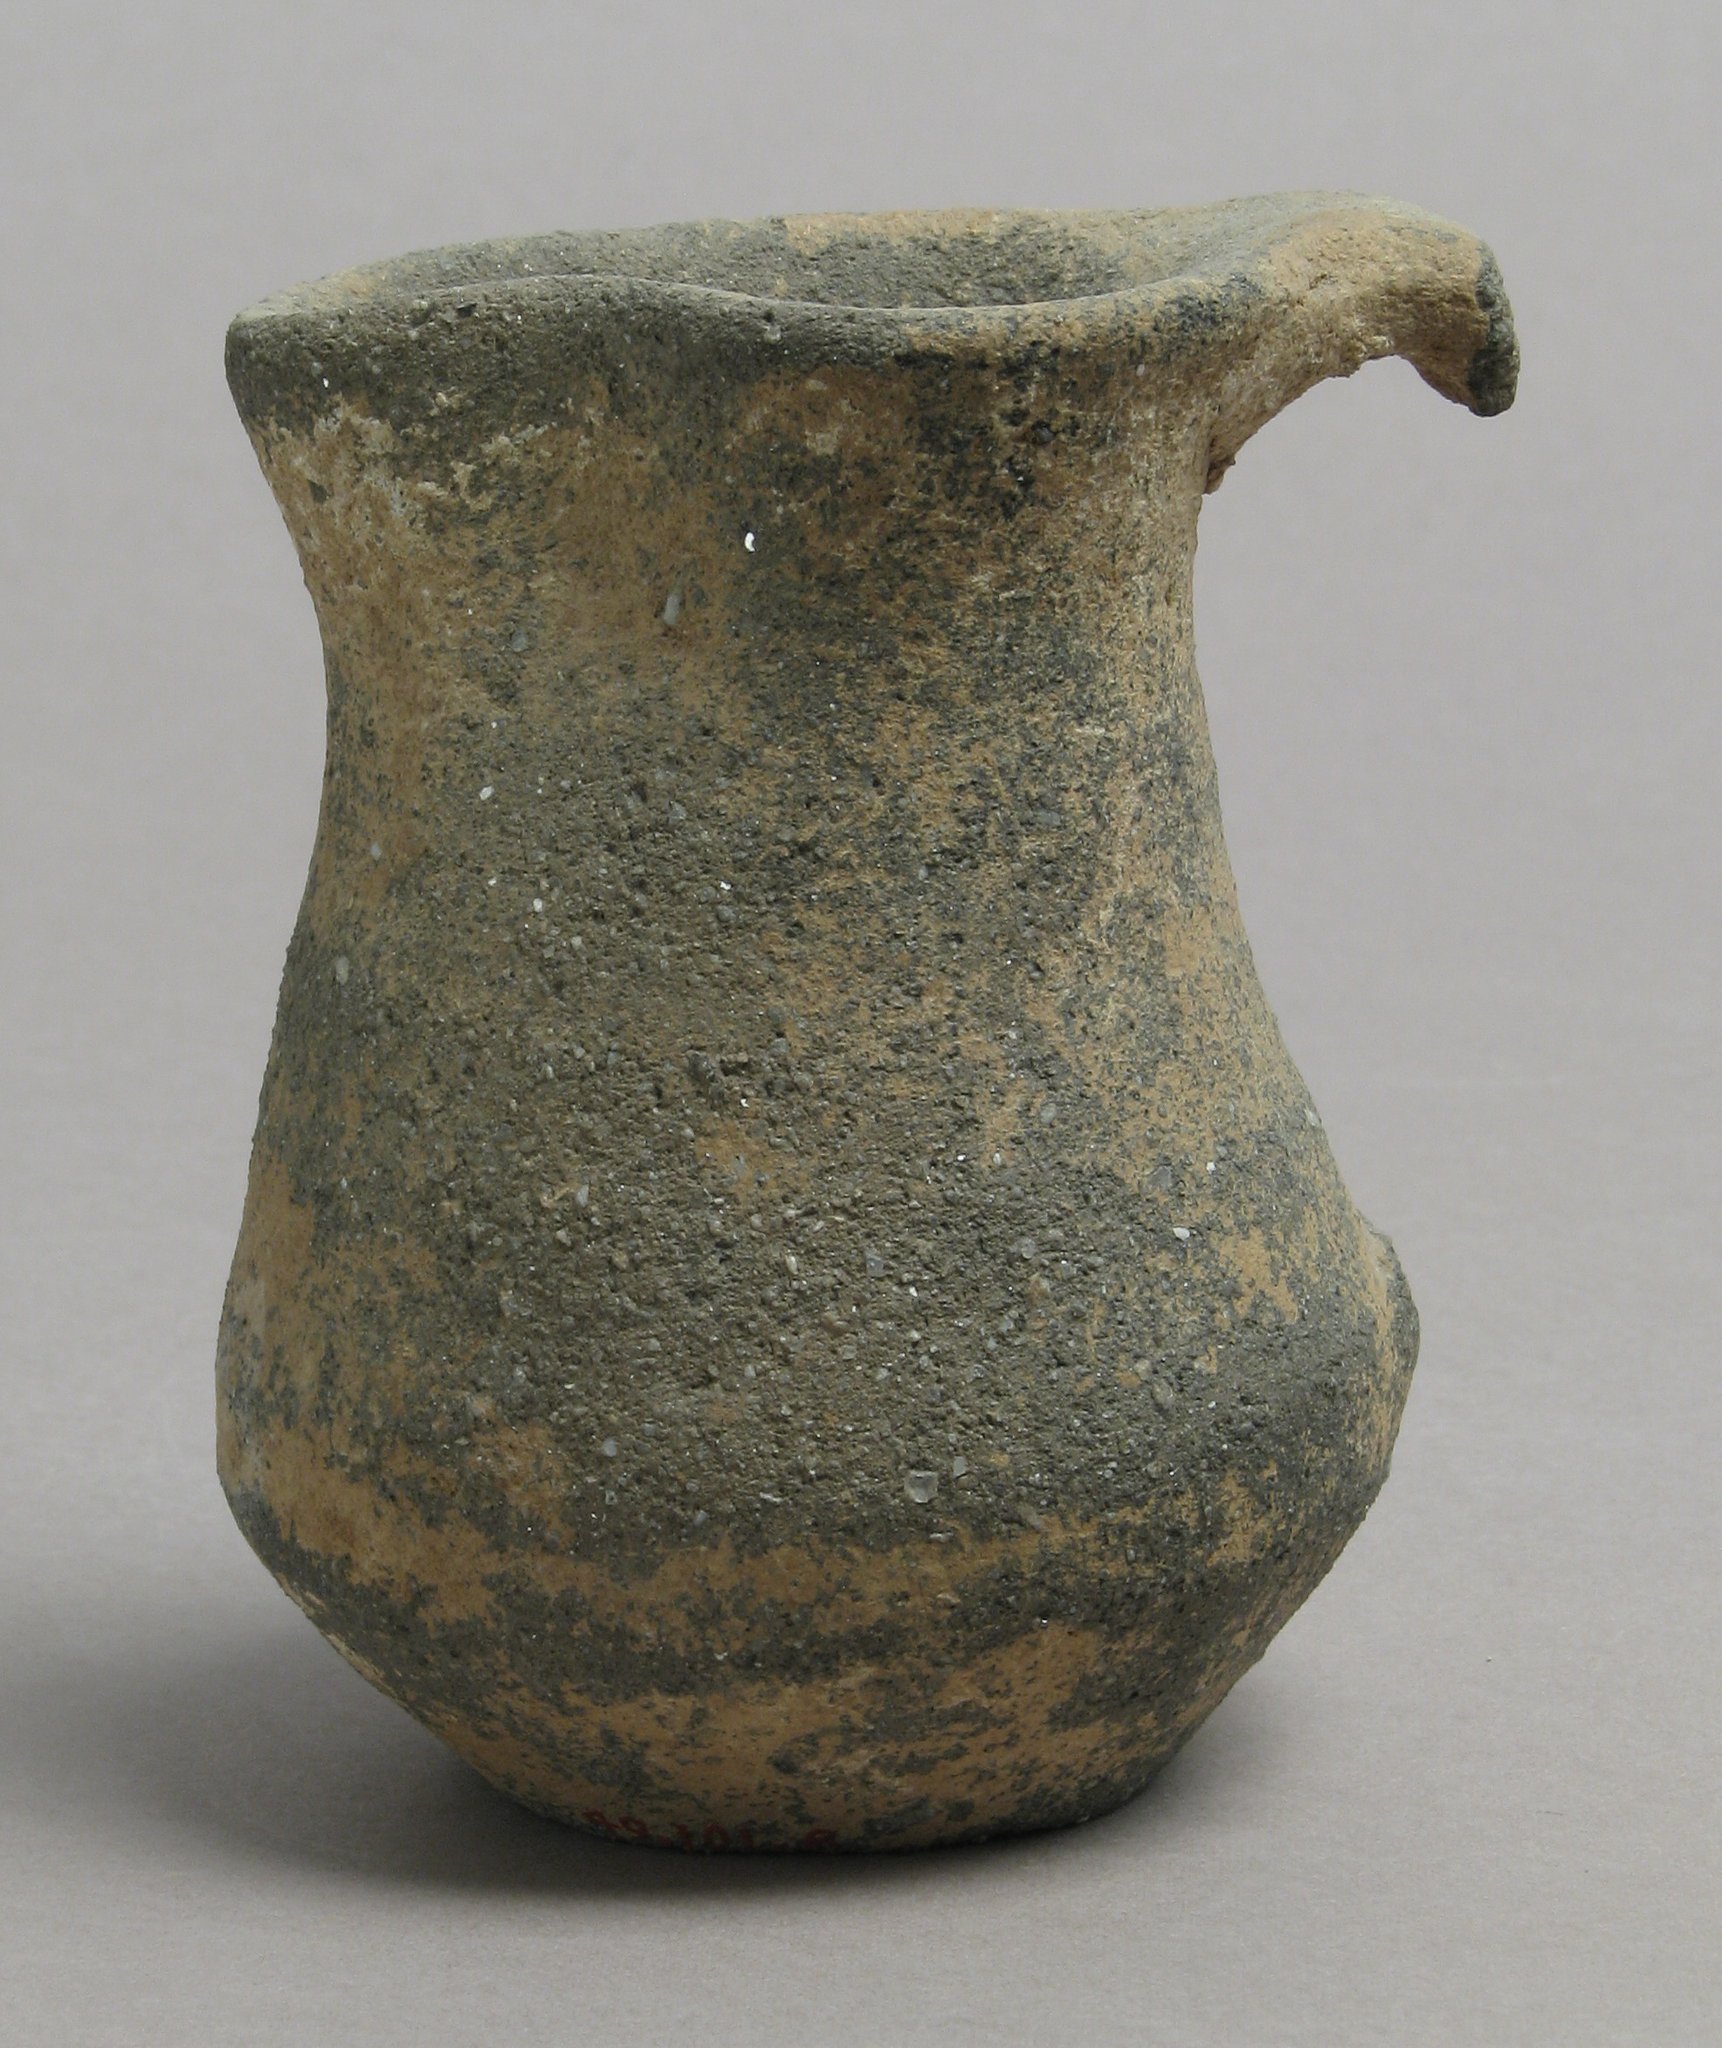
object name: vessel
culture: visigothic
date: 501-700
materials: earthenware